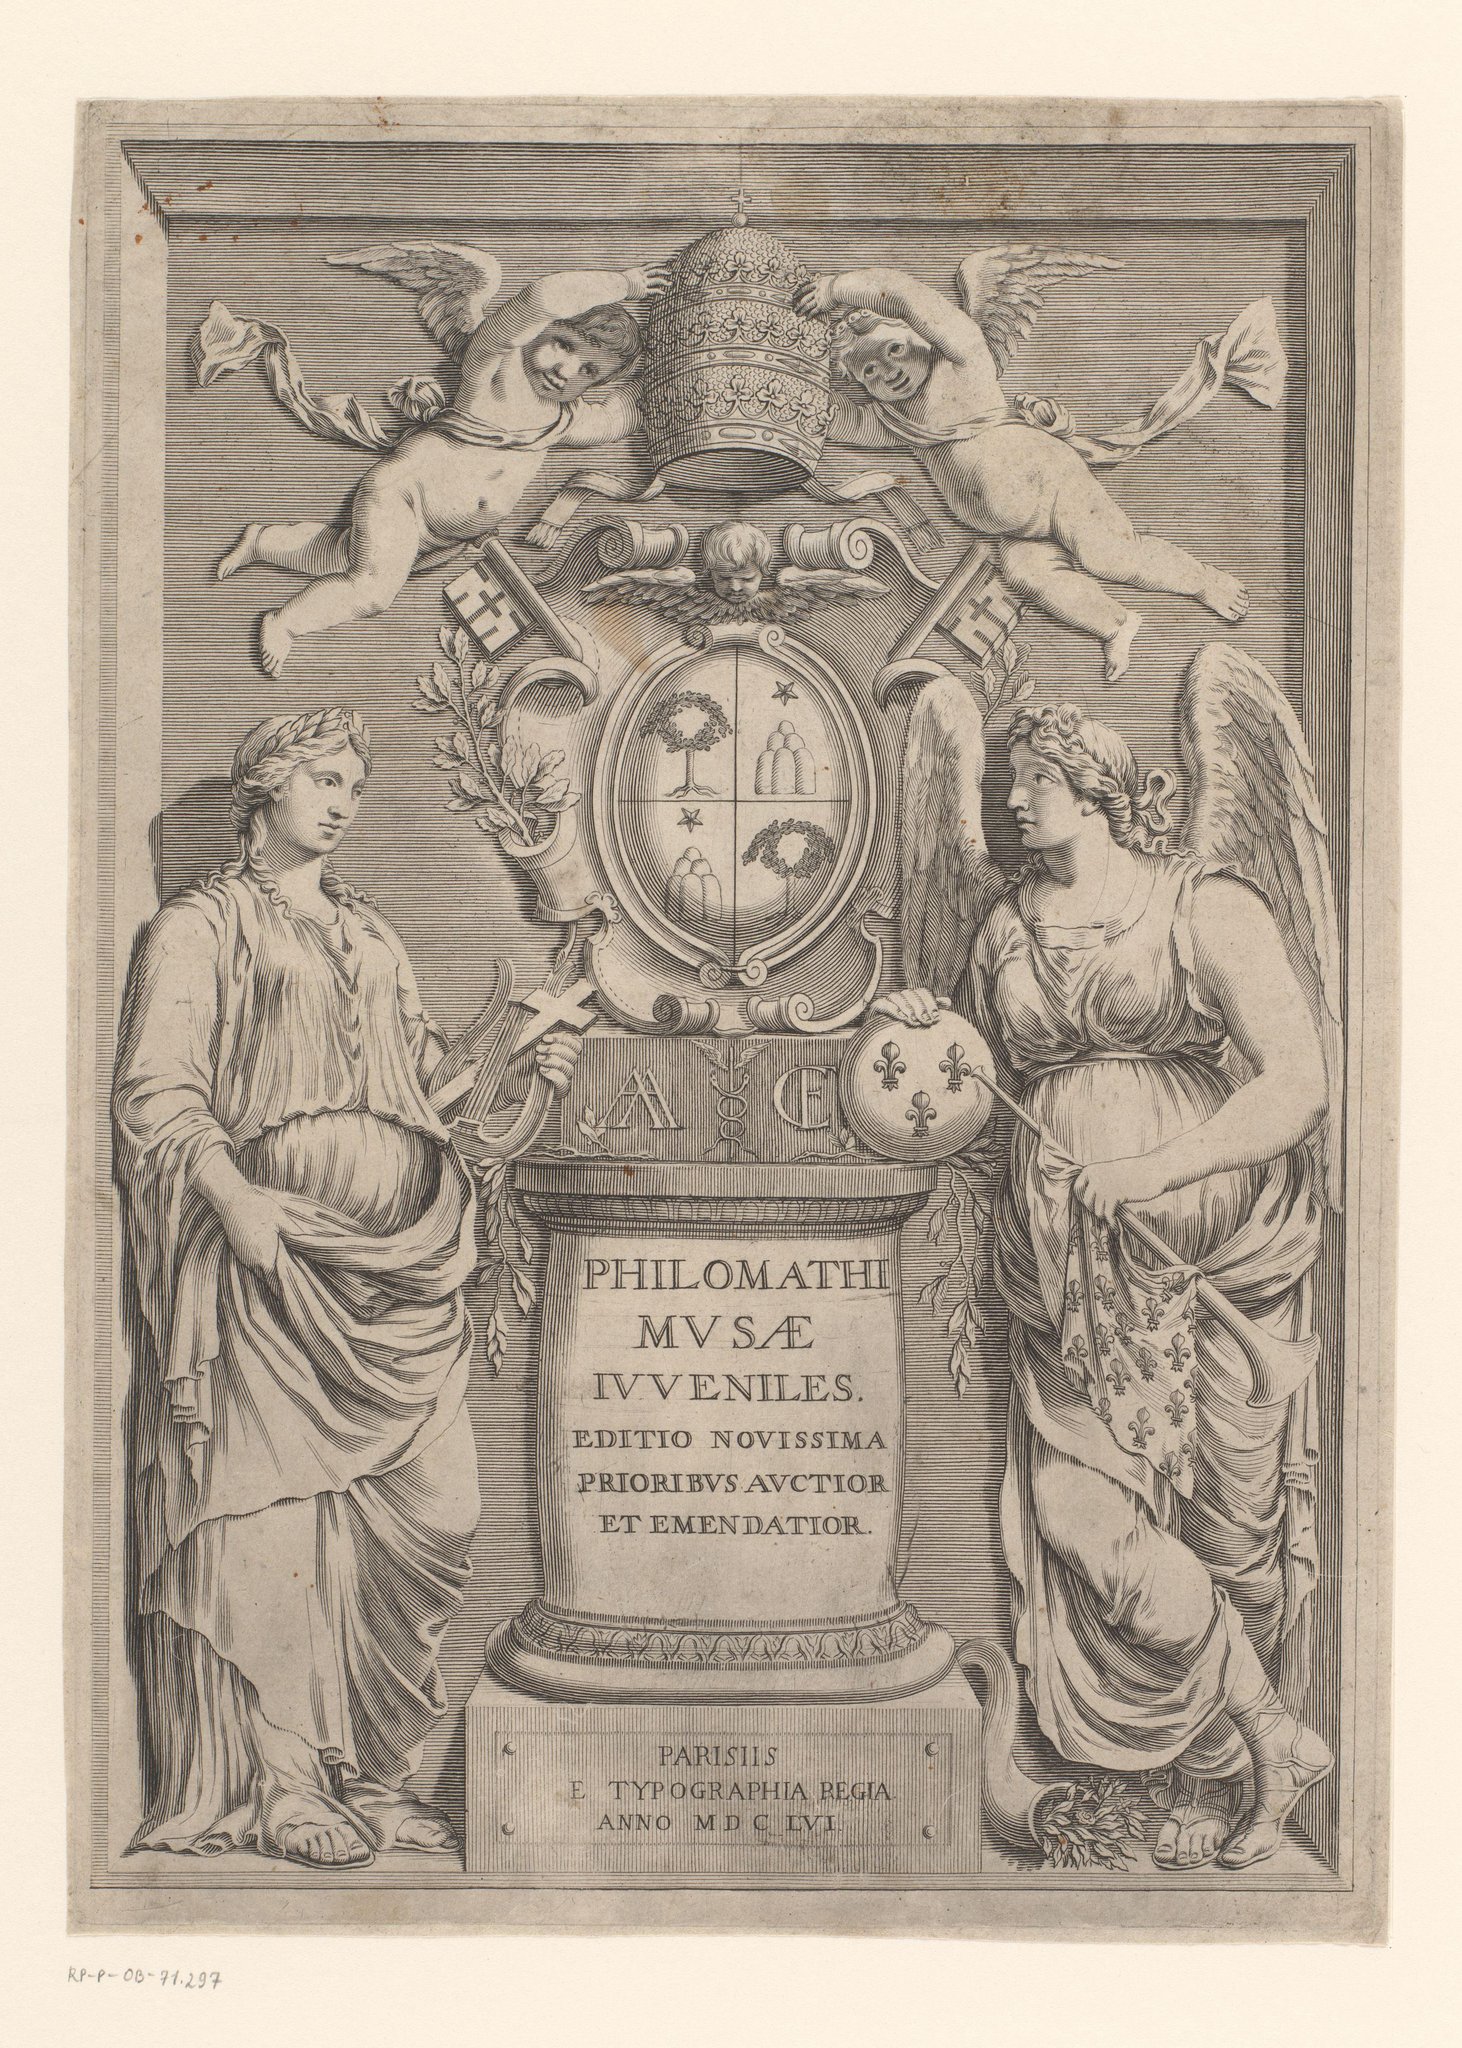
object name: print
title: Twee vrouwelijke figuren bij een wapenschild en de pauselijke tiara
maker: claude mellan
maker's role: draughtsman, print maker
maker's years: 1598-1688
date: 1656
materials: paper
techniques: engraving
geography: paris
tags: insignia of the pope, e.g. tiara, armorial bearing, heraldry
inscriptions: collector's mark: Lugt 240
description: Titelpagina voor: Paus Alexander VII. Philomathi musae ivveniles. Parijs: Imprimerie Royale, 1656.